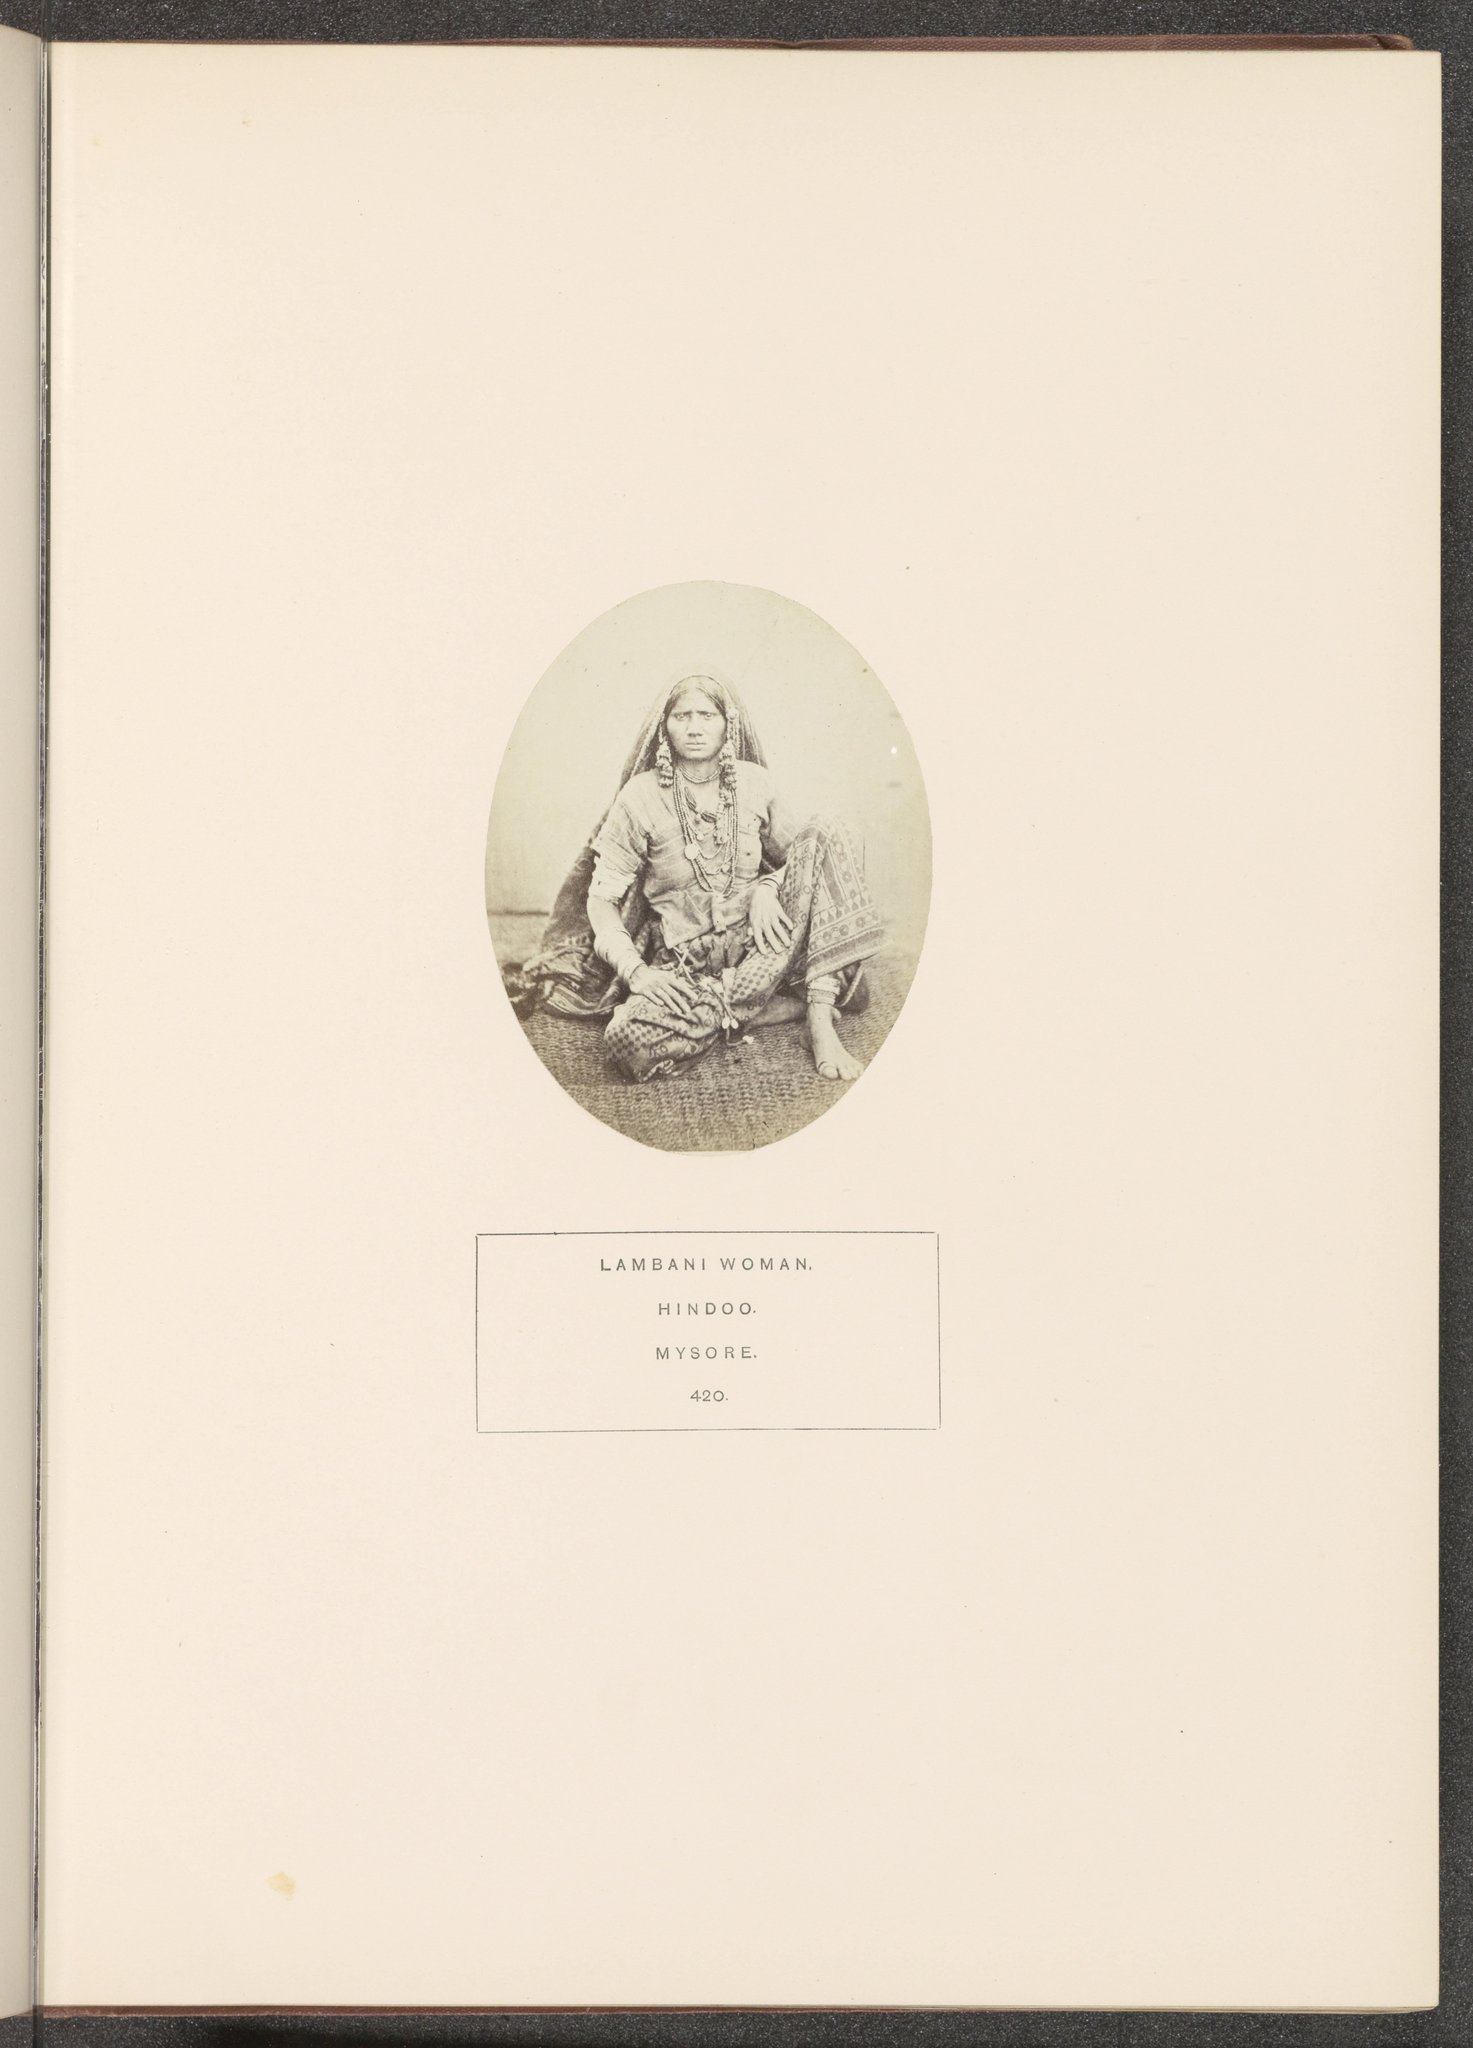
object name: photograph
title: Portrait of an unknown woman from the Lambani tribe of Mysore, Karnataka, India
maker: Anonymous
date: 1865-1875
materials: photographic support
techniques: albumen print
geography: mysore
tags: head-gear (with name), human races; peoples; nationalities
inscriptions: inscription: ‘LAMBANI WOMAN./ HINDOO./ MYSORE.’, number: ‘420.’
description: De Lambani-stam is ook bekend als Banjara.